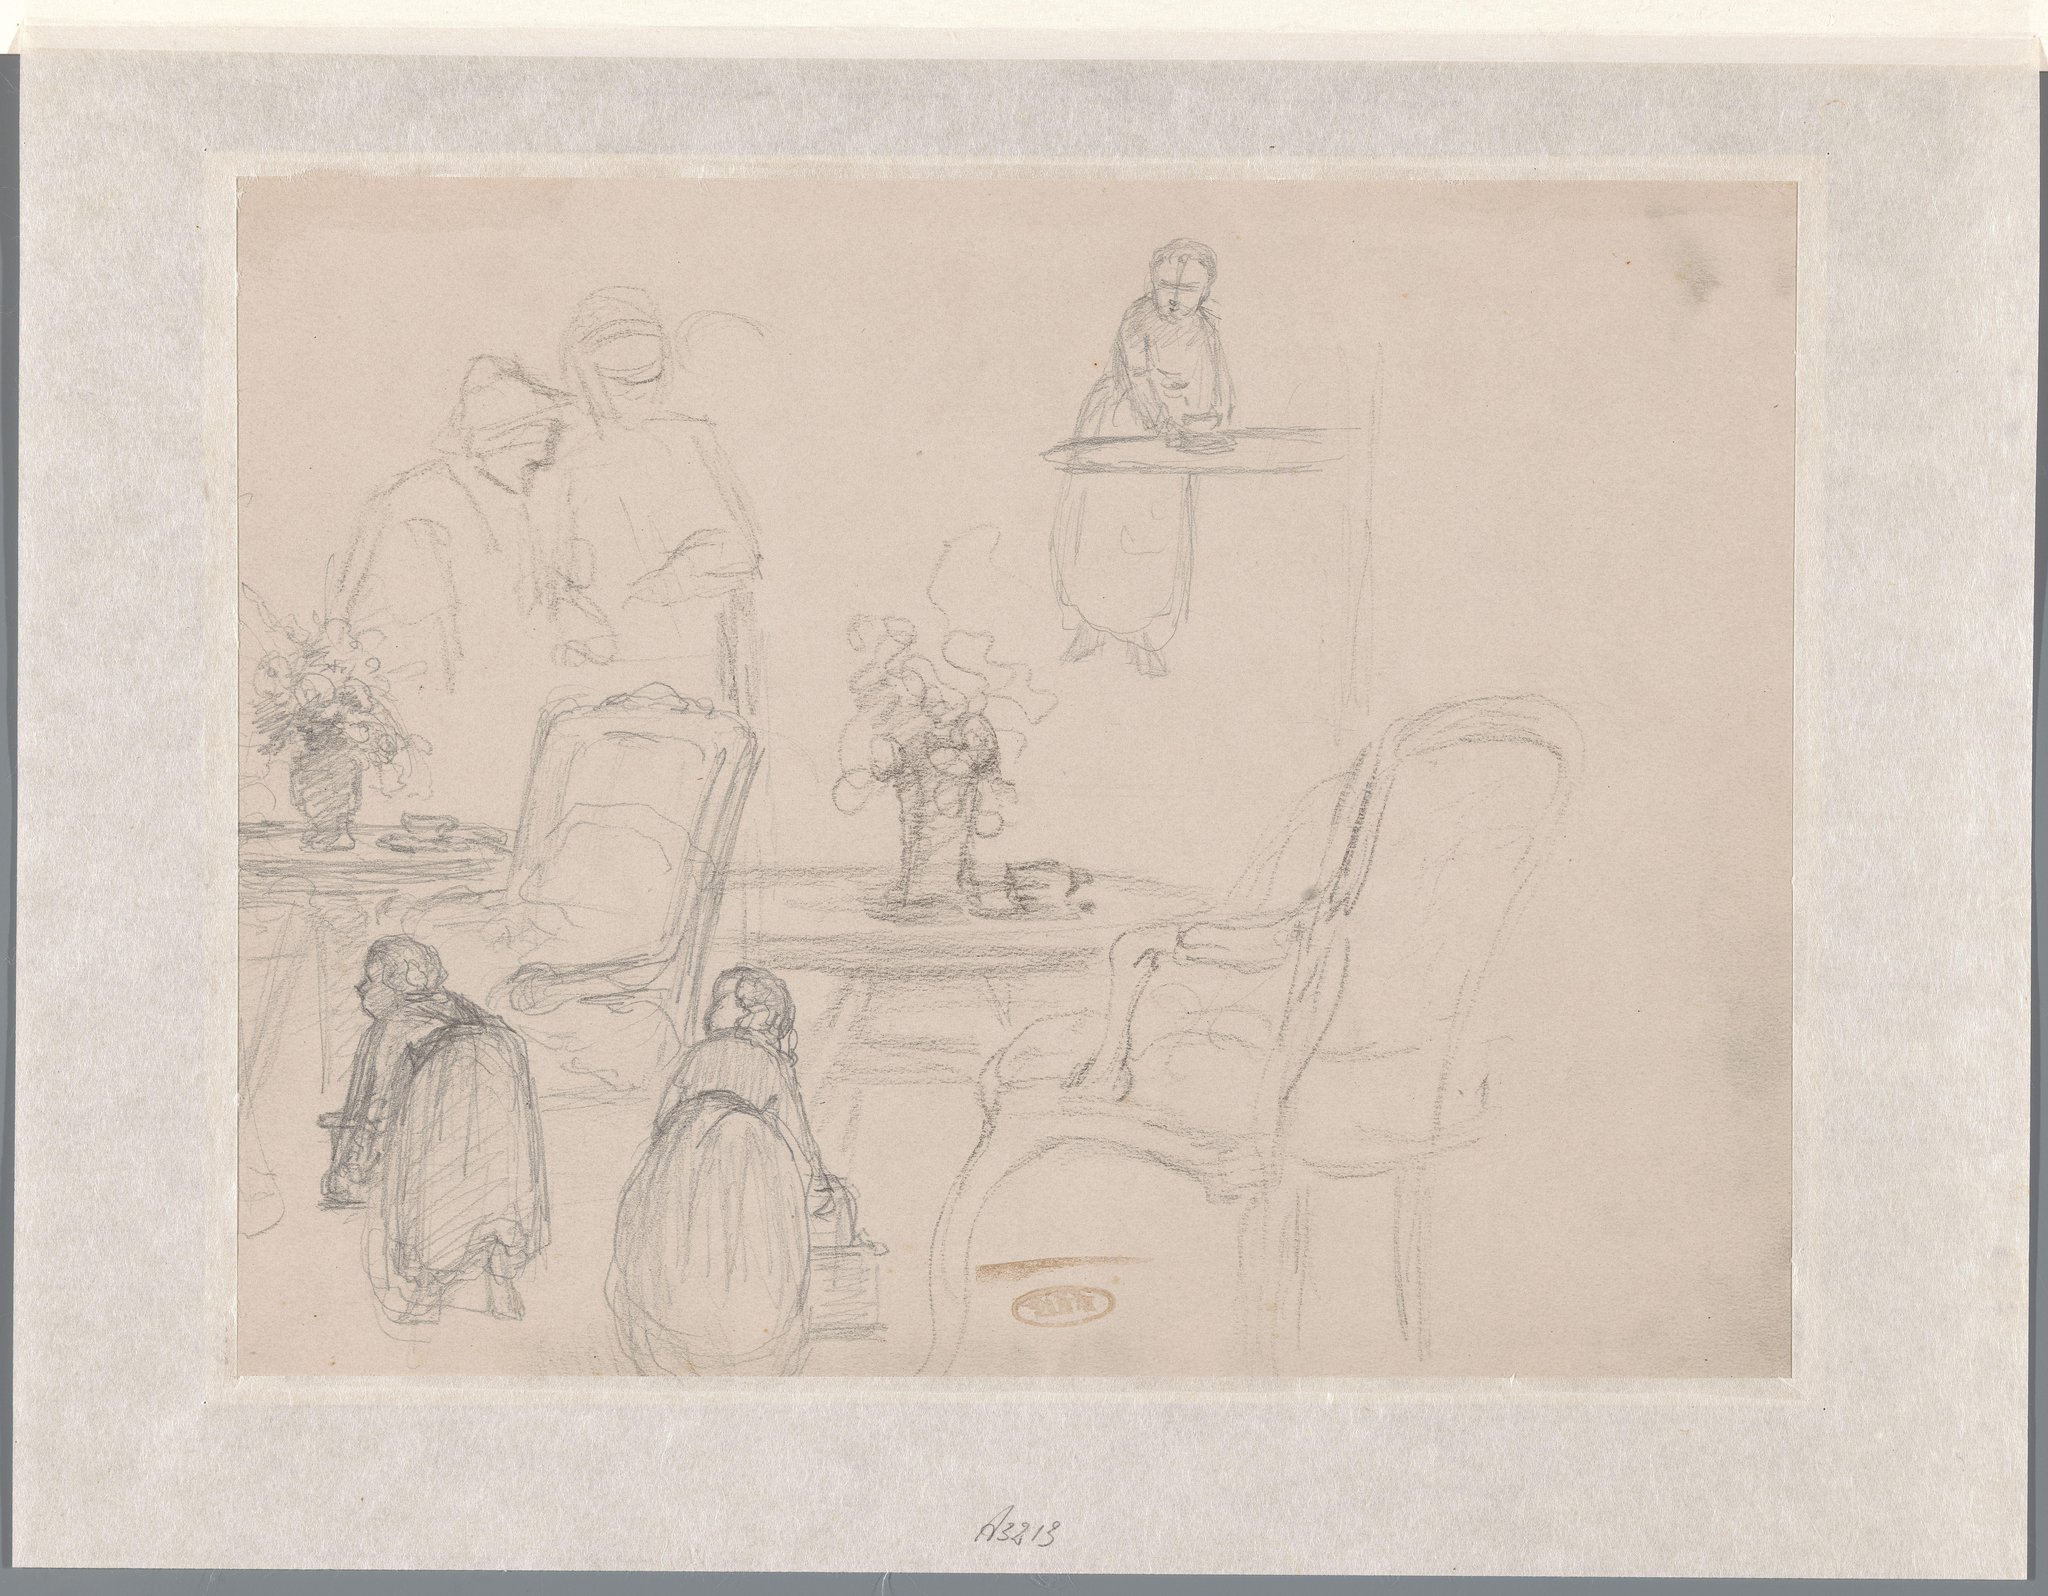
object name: drawing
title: Interieur met dienstmeiden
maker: hendrik valkenburg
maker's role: draughtsman, painter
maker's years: 1826-1896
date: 1836-1896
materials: paper, pencil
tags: baby-chair